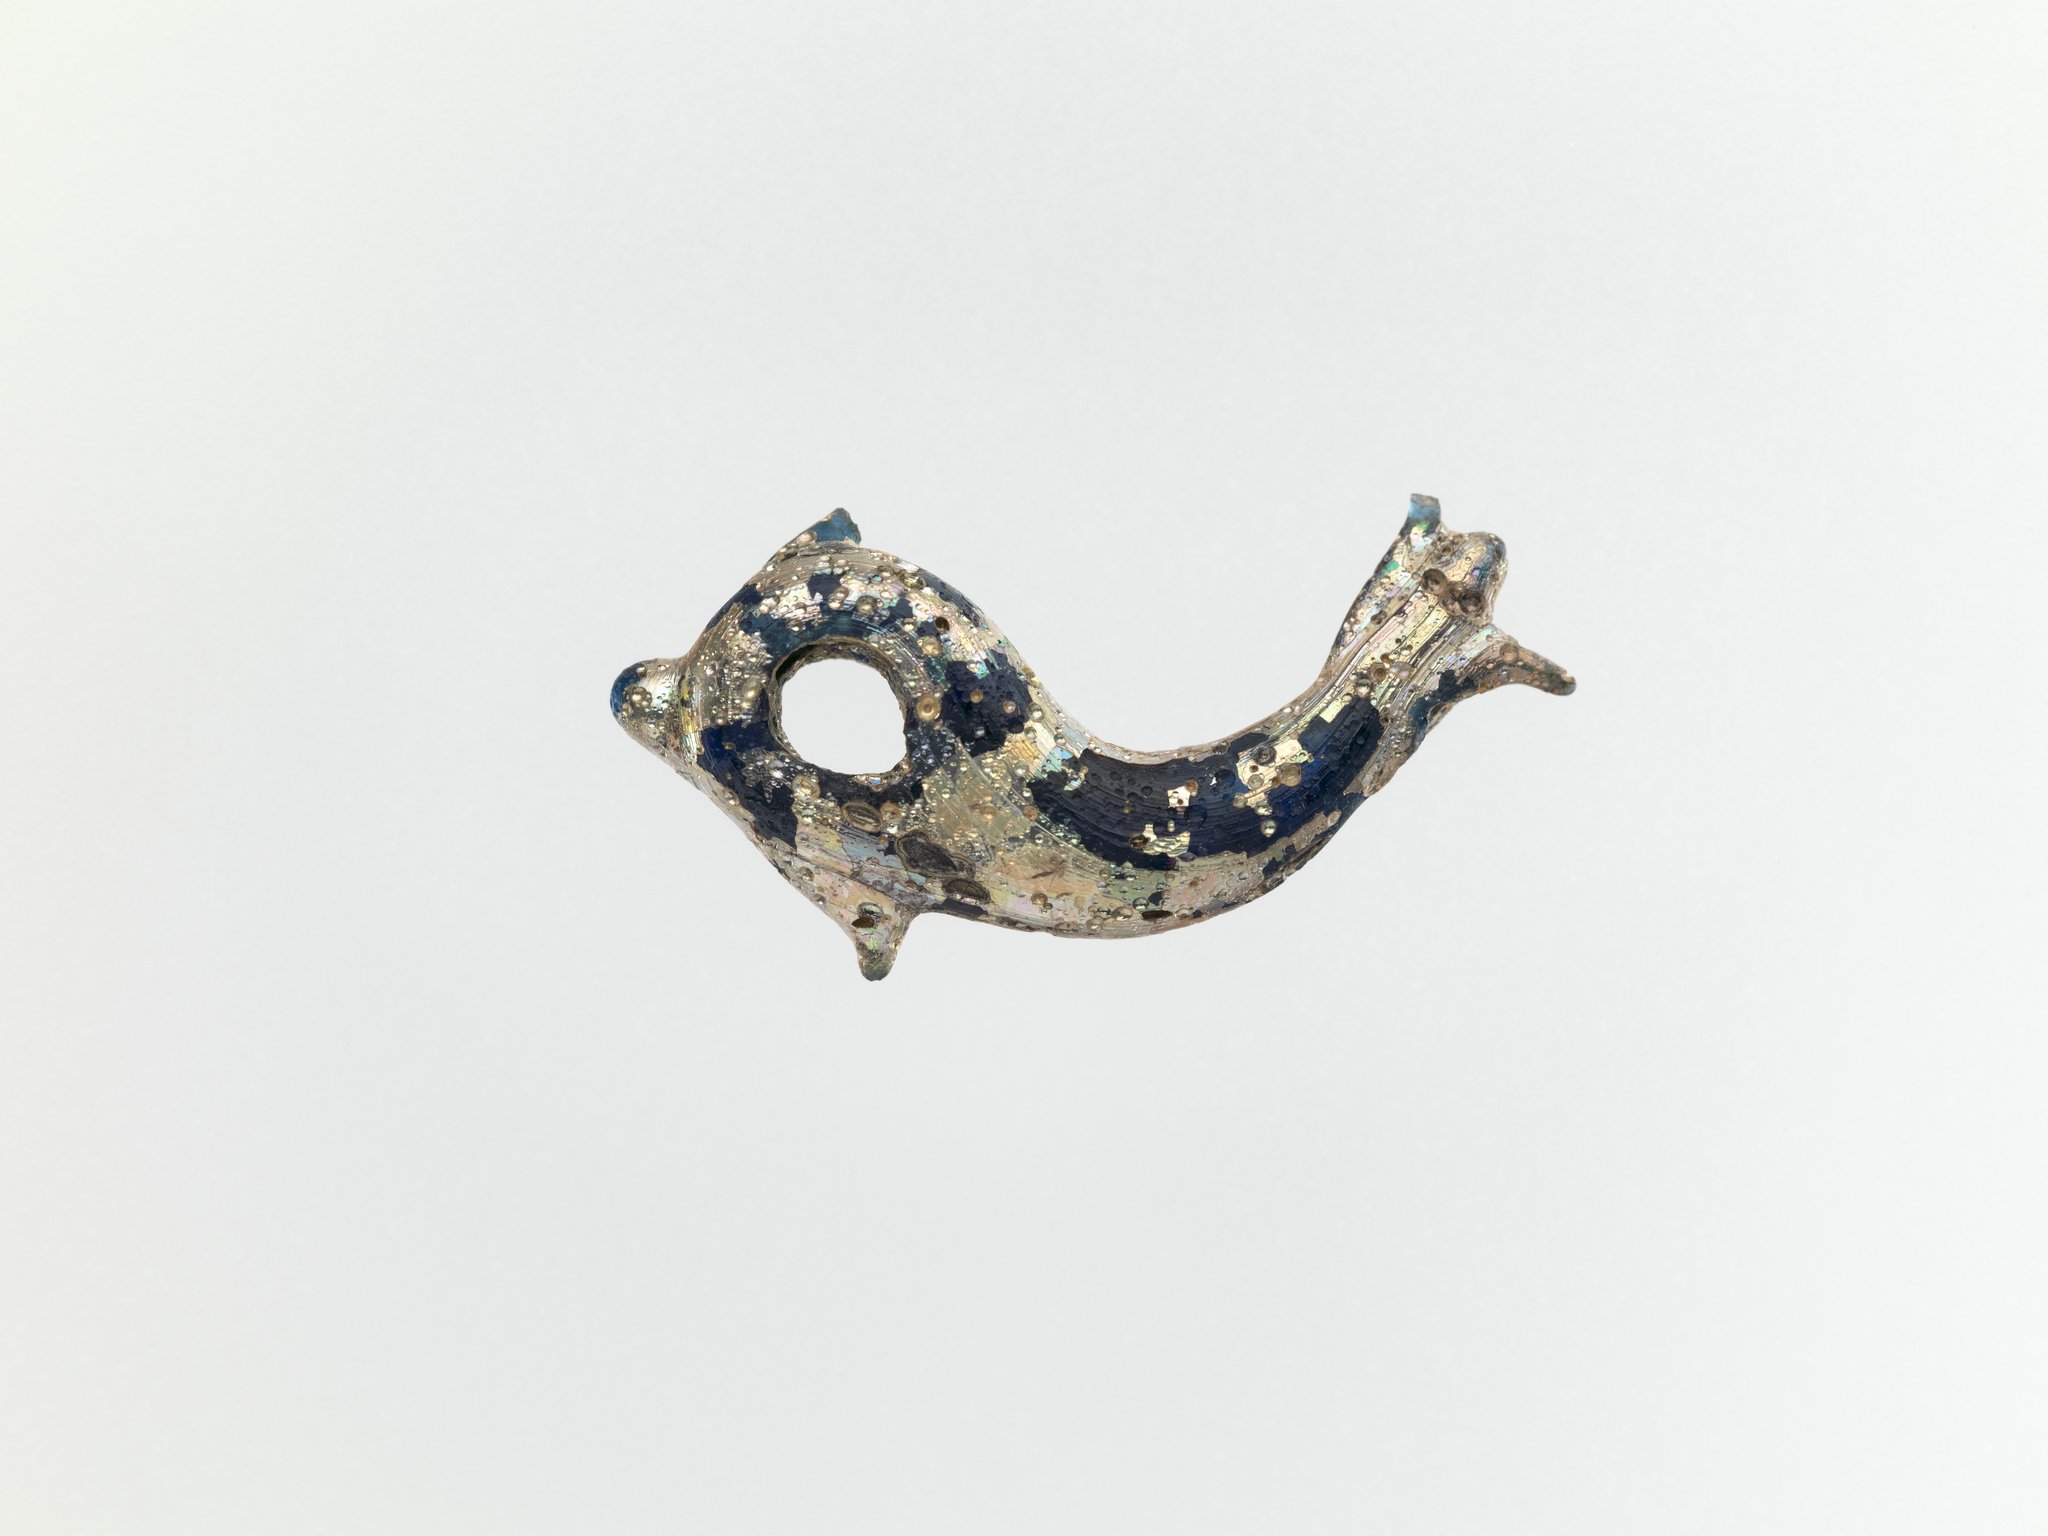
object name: pendant in the form of a dolphin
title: Glass pendant in the form of a dolphin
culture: roman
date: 201-500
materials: glass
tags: dolphins